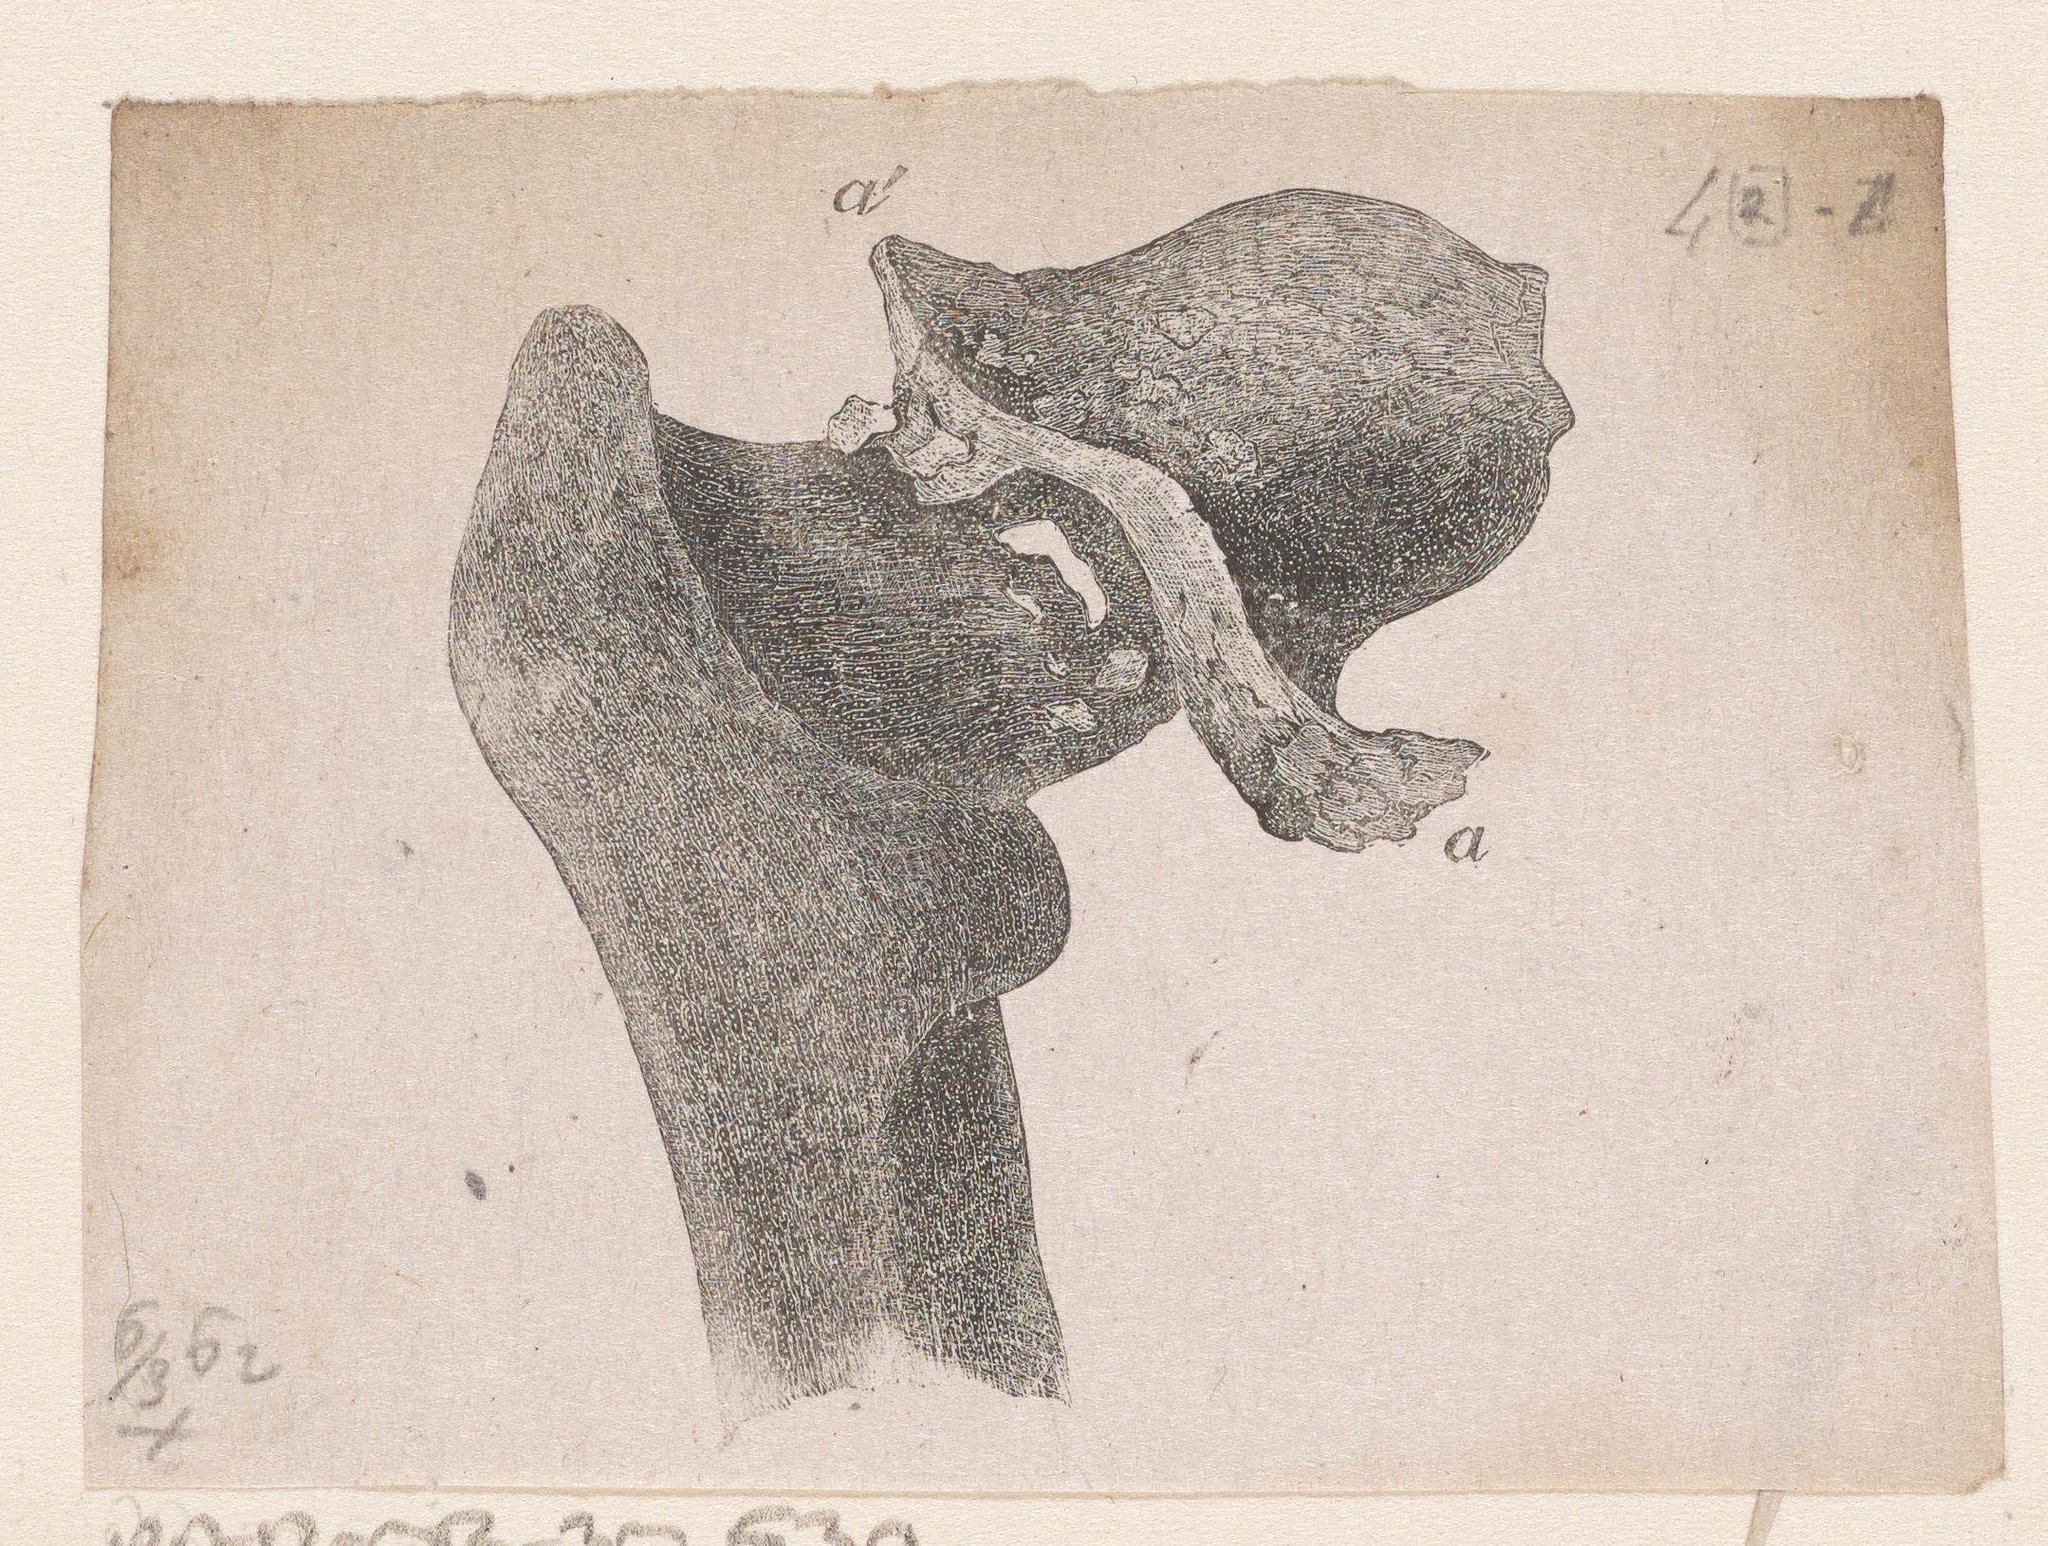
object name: print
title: Menselijk bot met een afwijking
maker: isaac weissenbruch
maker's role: print maker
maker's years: 1826-1912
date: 1836-1912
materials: paper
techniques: engraving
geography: netherlands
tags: bones in general (human body), diseases